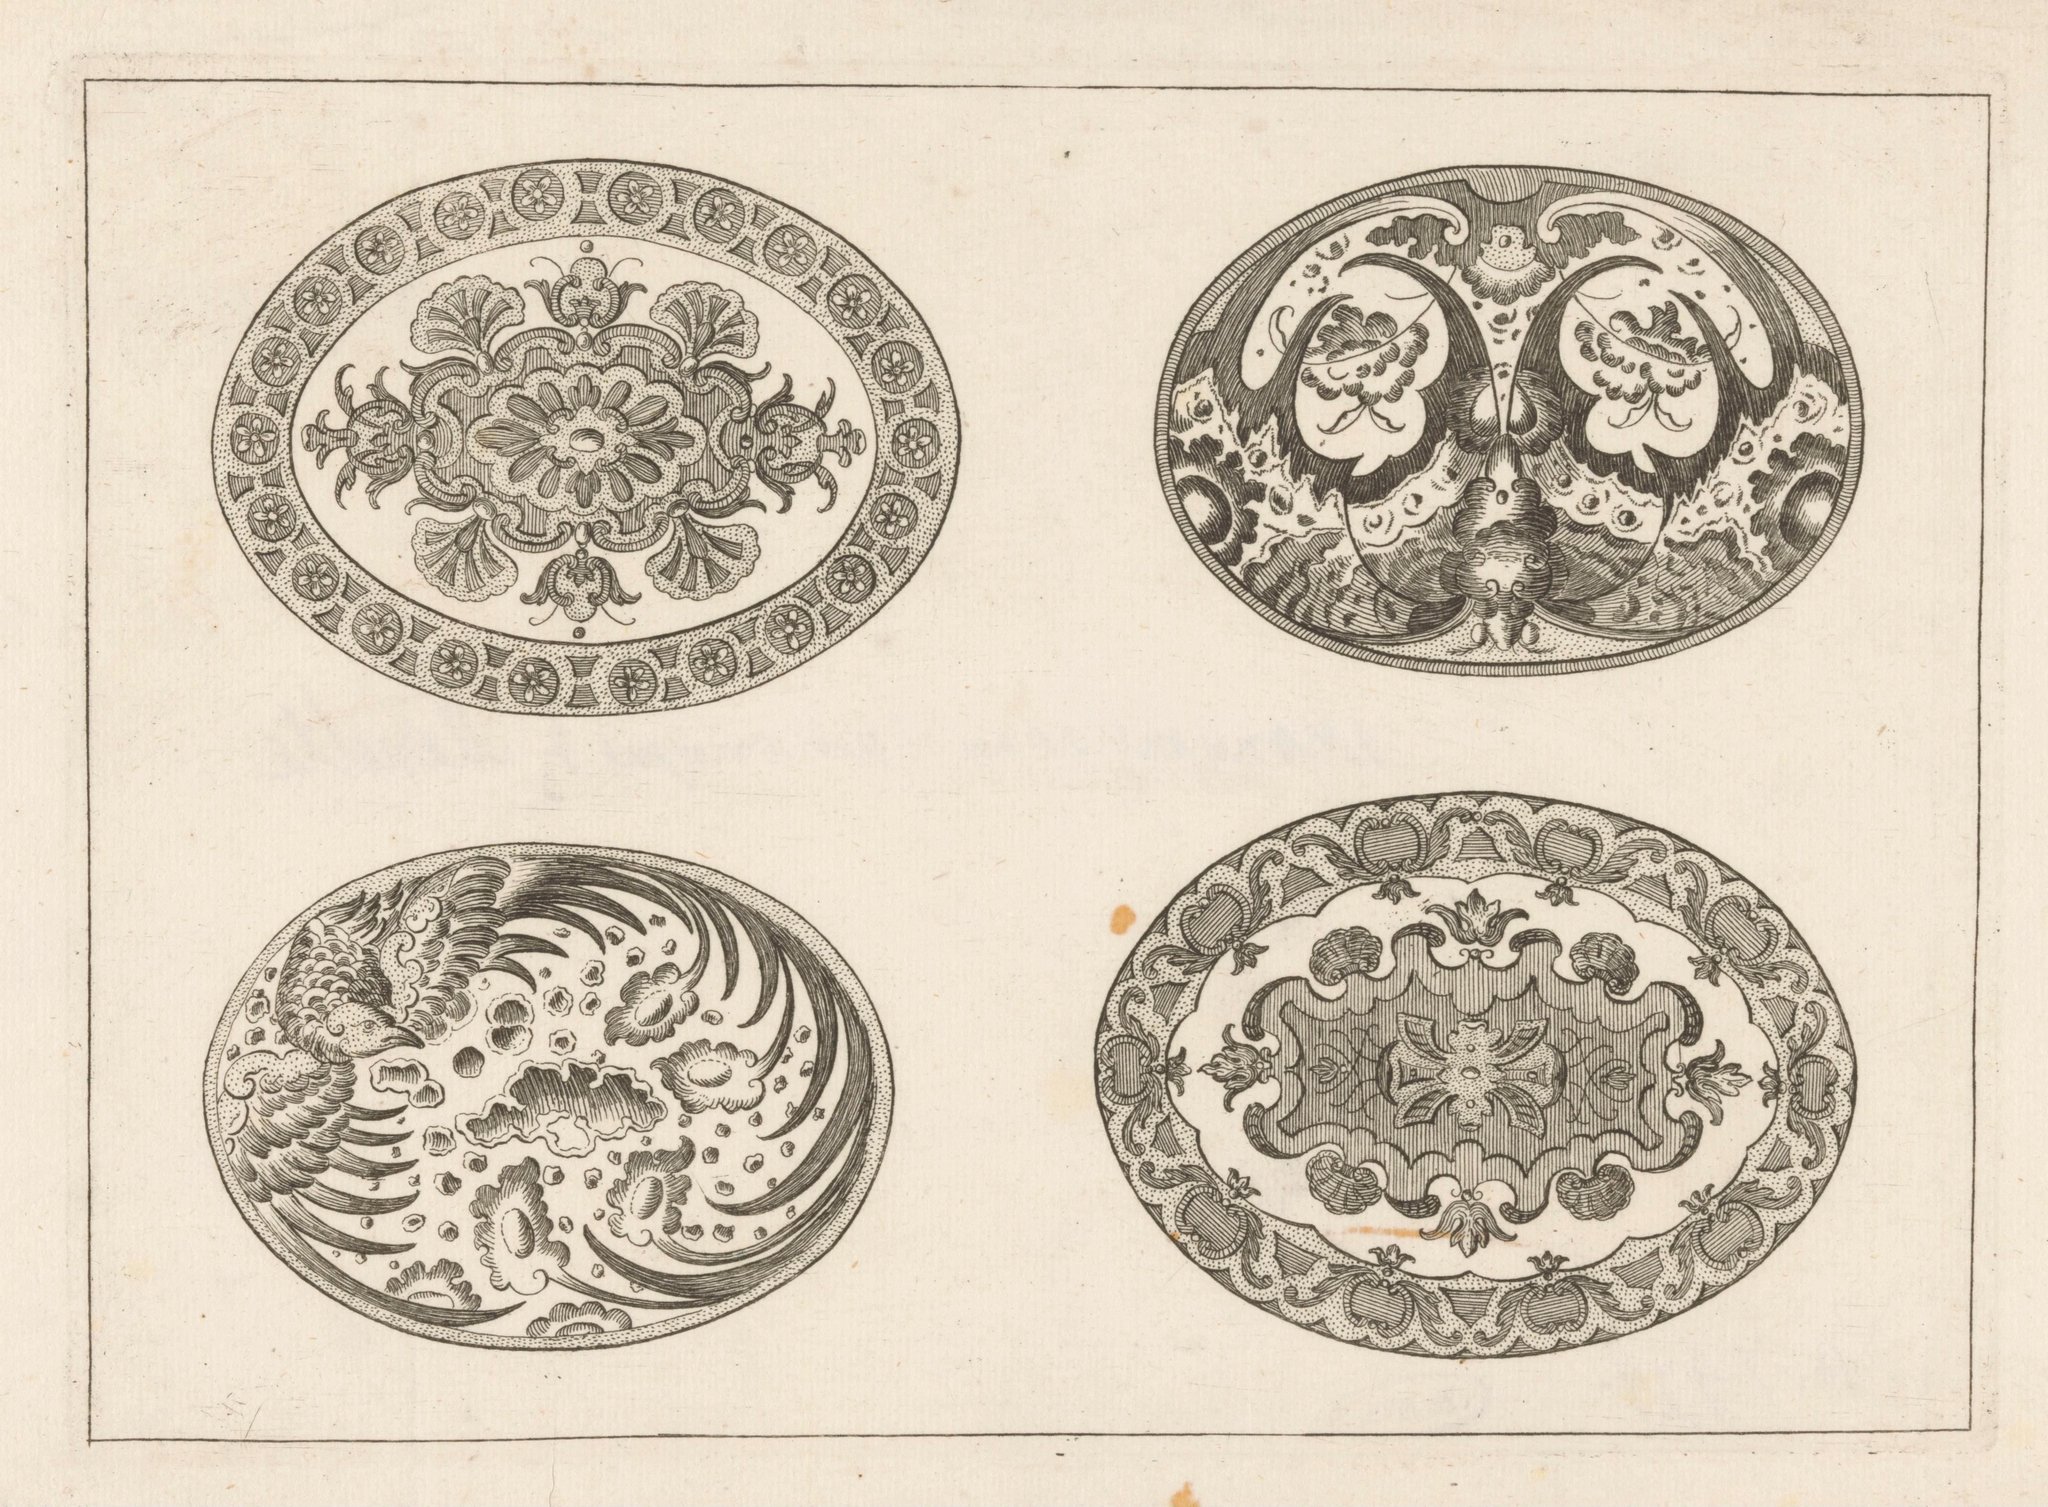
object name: ornament print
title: Deksels met vlinder en vogel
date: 1670-1725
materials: paper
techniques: etching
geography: germany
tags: snuff-box, birds, insects: butterfly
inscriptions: collector's mark: Lugt 2228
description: Vier deksels van snuifdozen. Links boven en rechts onder met ornamenten. Rechts boven met een vlinder. Links onder met een vogel.